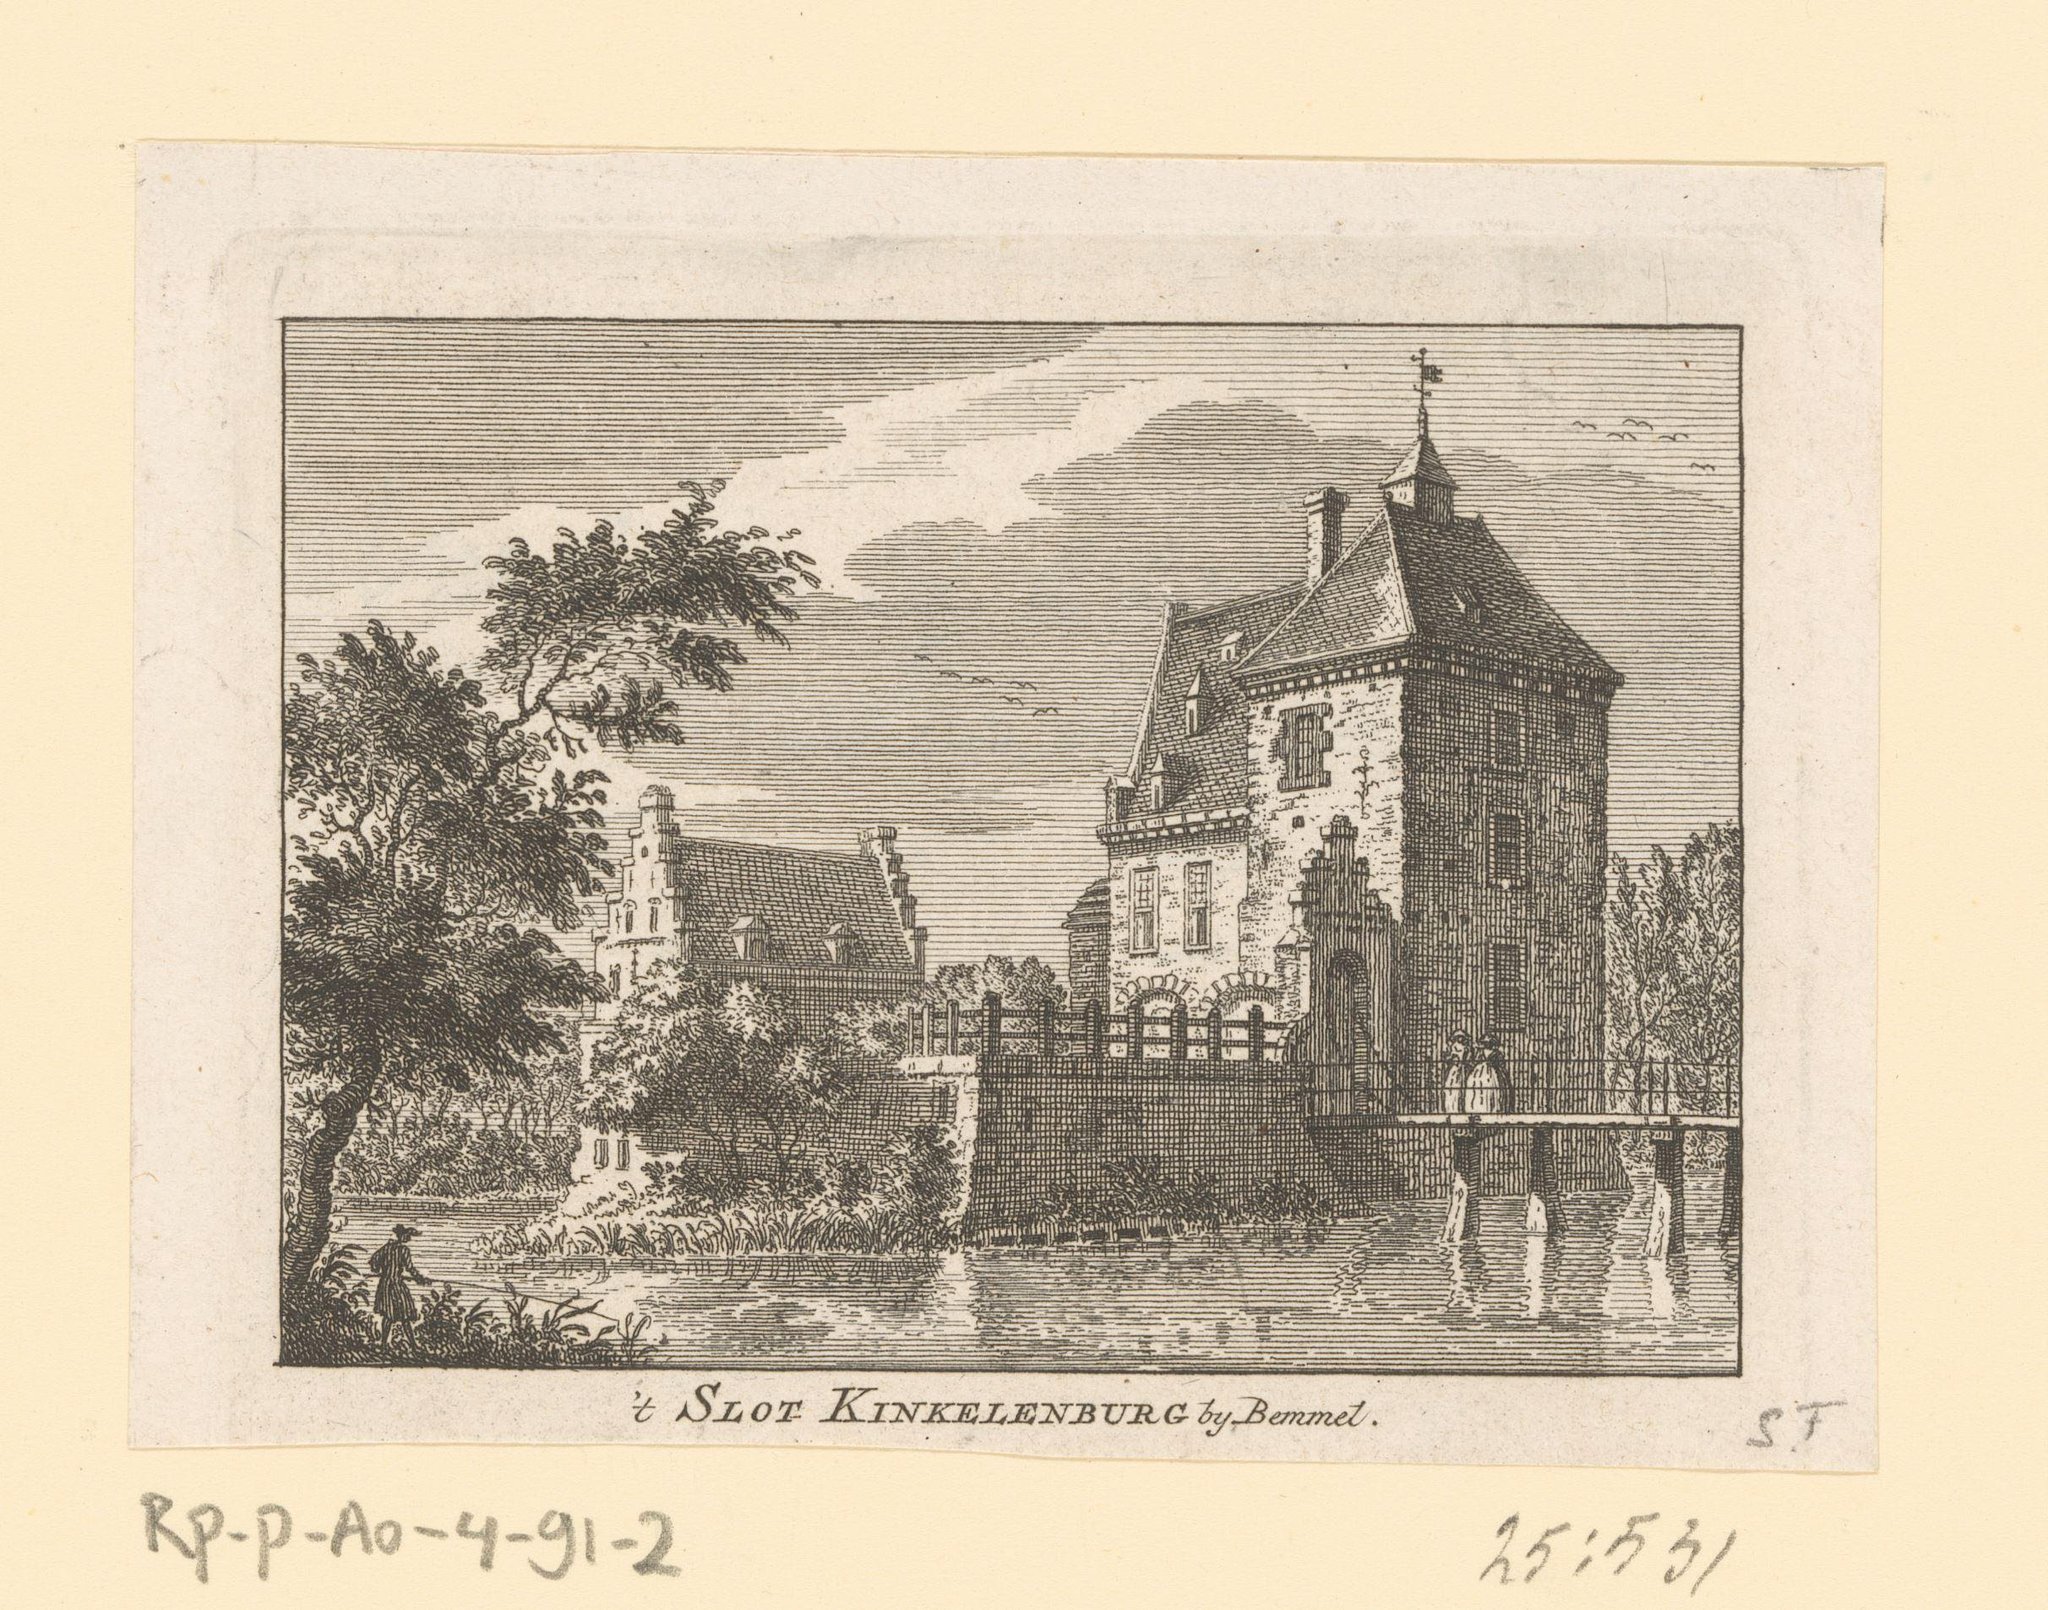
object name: print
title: 't Slot Kinkelenburg by Bemmel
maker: simon fokke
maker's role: draughtsman, print maker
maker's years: 1712-1784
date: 1745-1792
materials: paper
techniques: etching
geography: amsterdam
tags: castle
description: Prent ook gebruikt in: Het verheerlykt Nederland of kabinet van hedendaagsche gezigten van steden, dorpen (…). 9 delen. Amsterdam: Isaak Tirion en weduwe Isaak Tirion, 1745-1774, dl. 1 (1745), ill. 35. Of in: Nederlandsche tafereelen; of eene keurige verzameling van negen honderd fraaije gezigten van steden, dorpen, sloten, oudheden (….). 9 delen. Amsterdam: Jan de Groot, 1792, dl. 1, ill. 35.